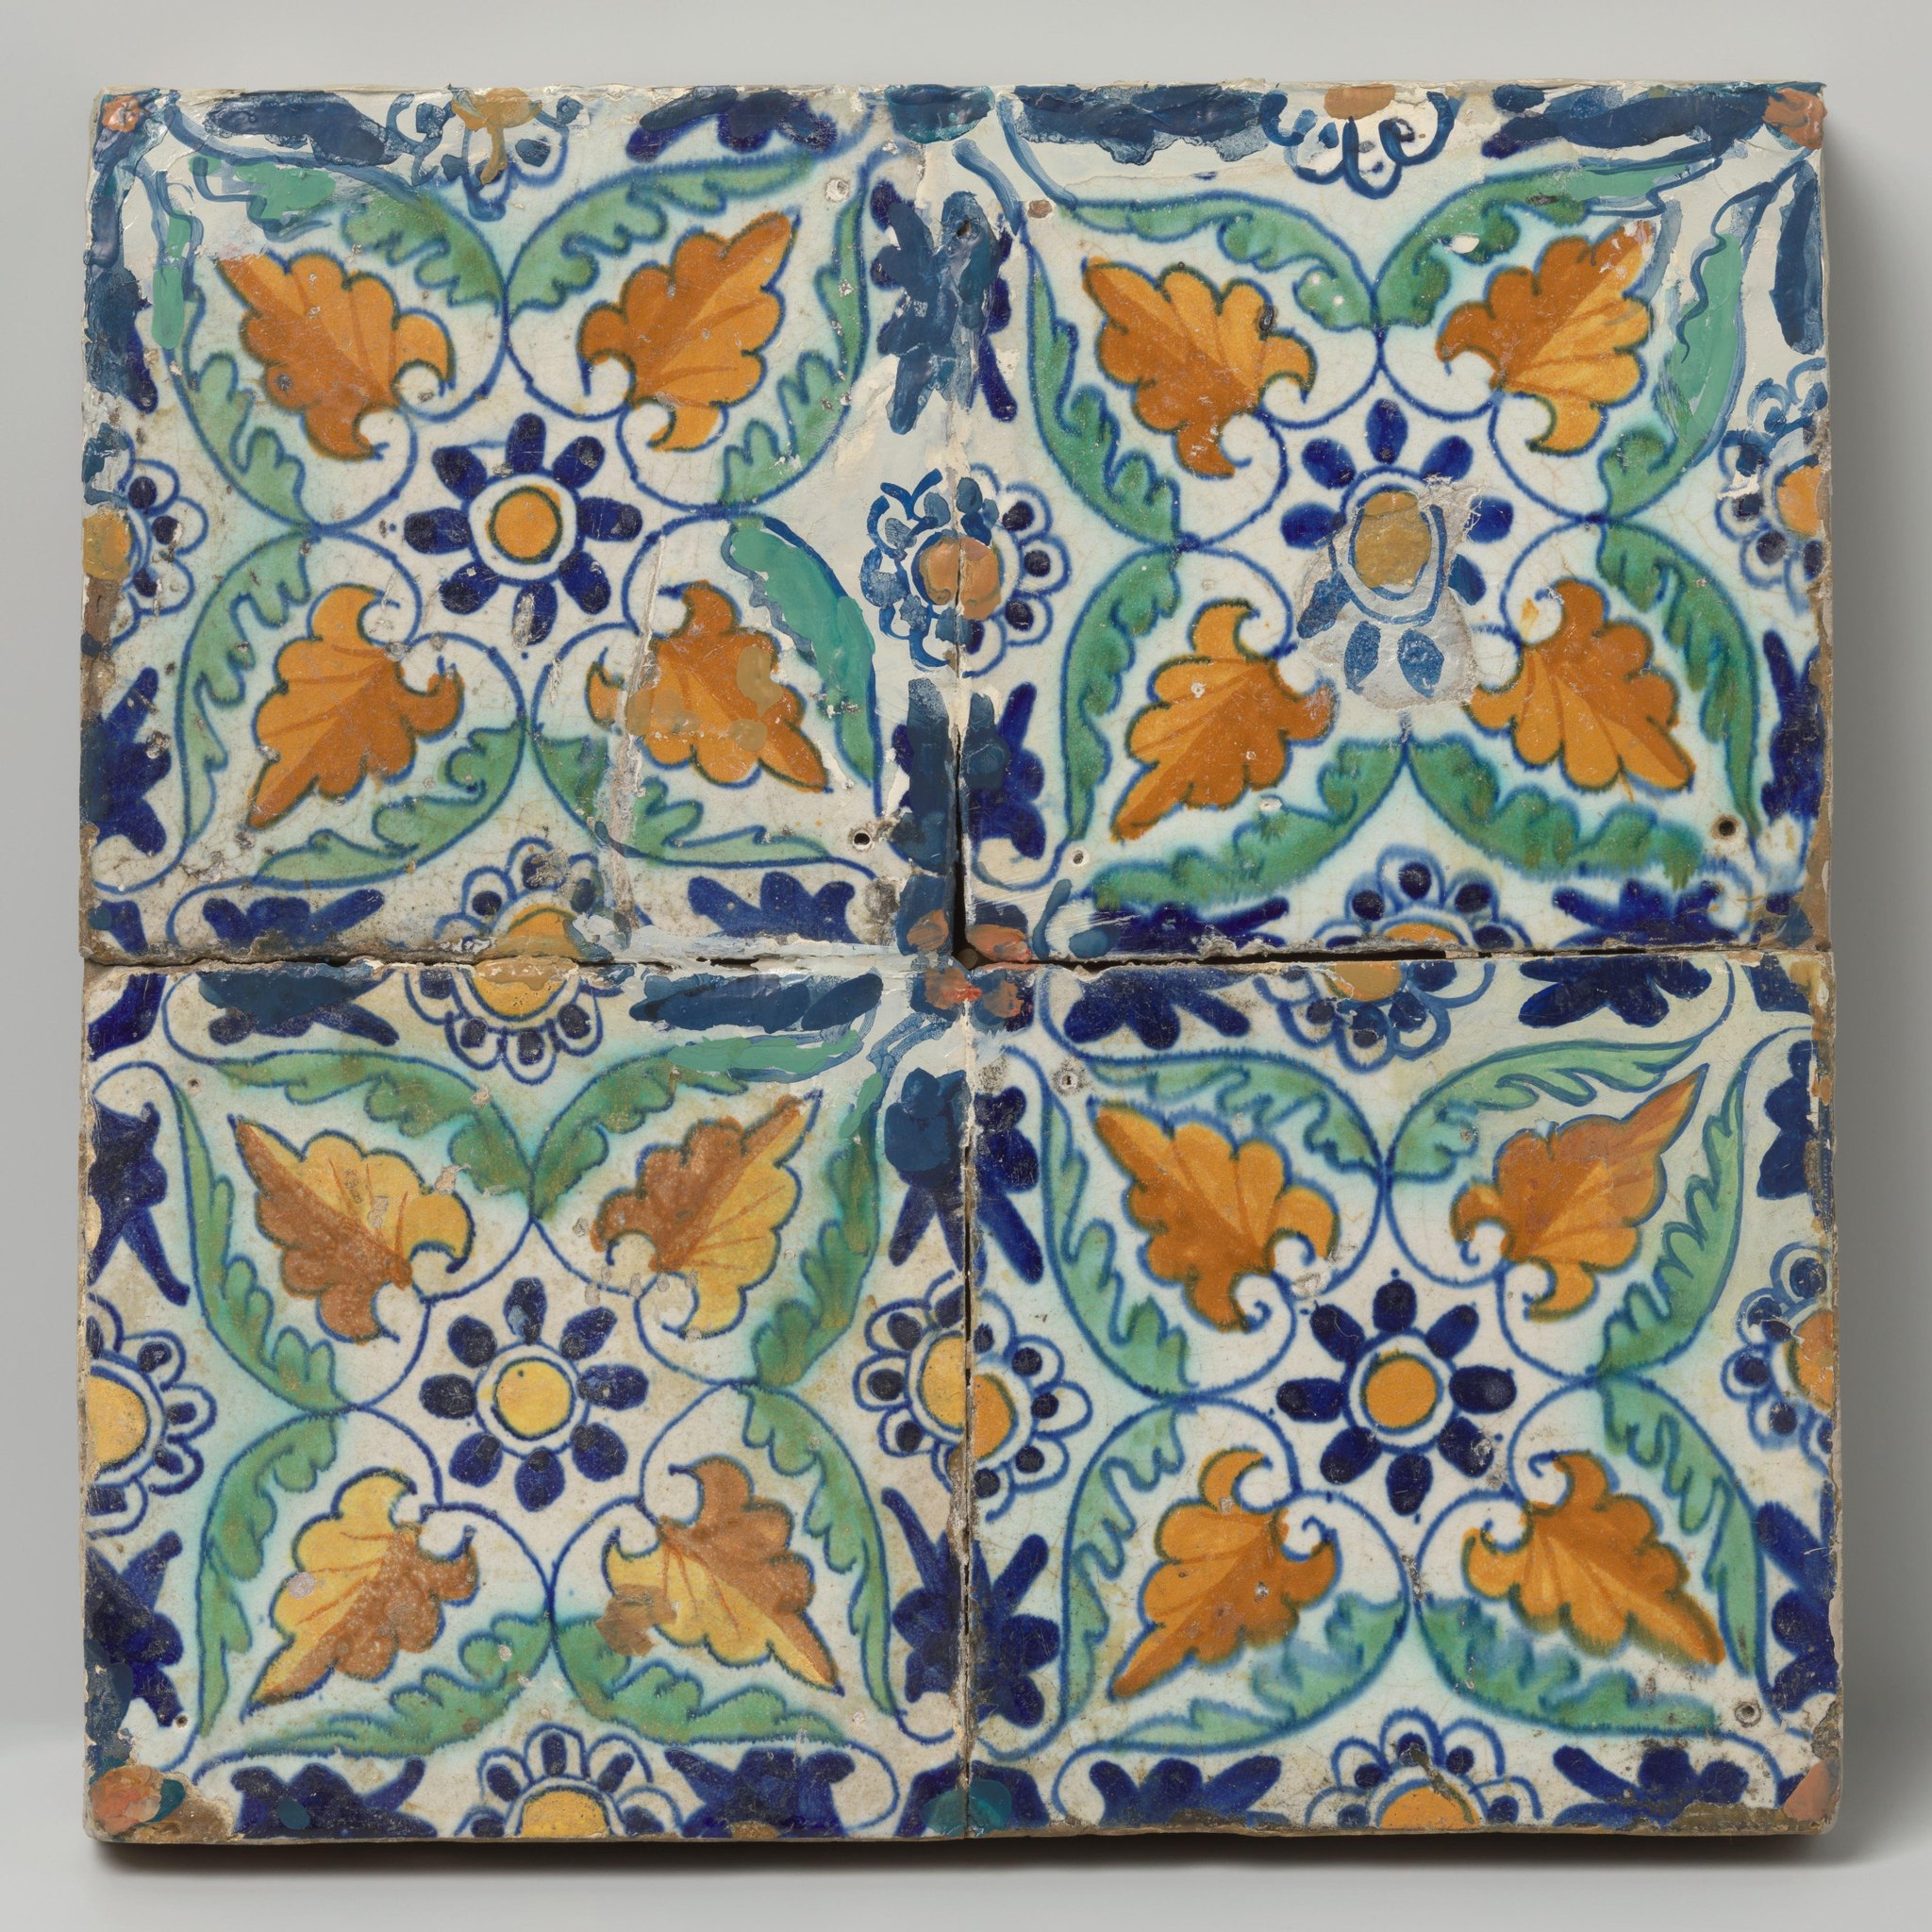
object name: tegelveld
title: Veld van vier tegels met rozetten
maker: Anonymous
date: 1600-1630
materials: earthenware, glaze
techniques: maiolica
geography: netherlands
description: Veld van vier tegels (2 x 2) elk met een veelkleurige (blauw, oranje, groen en geel) rozet omgeven door vier bladeren in de hoeken. Langs de randen, een halve rozet.